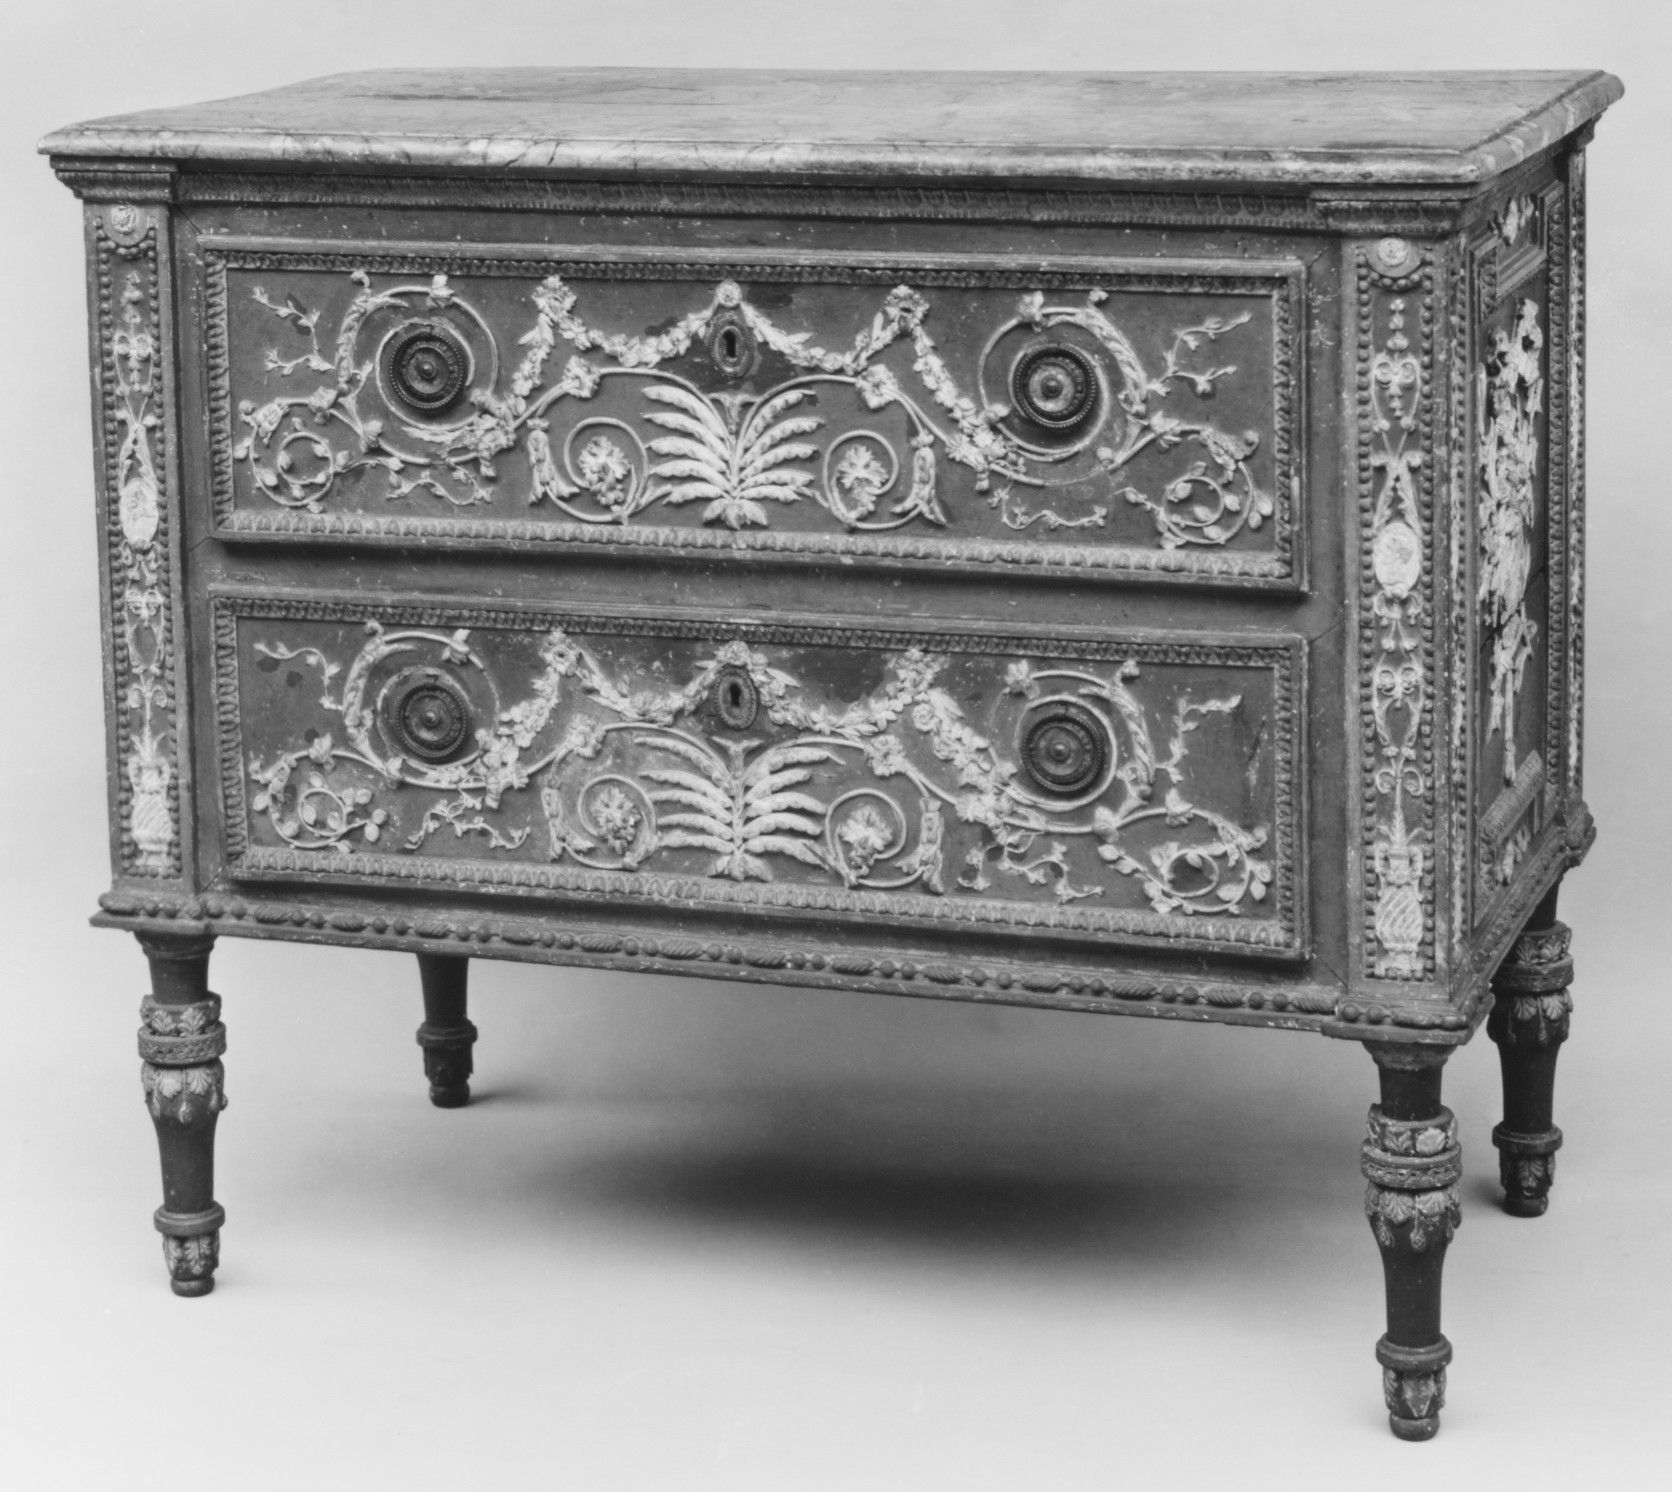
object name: commode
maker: francesco bozelli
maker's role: maker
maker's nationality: italian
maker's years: 1750-1850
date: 1770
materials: brass, gesso, marble, wood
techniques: painting